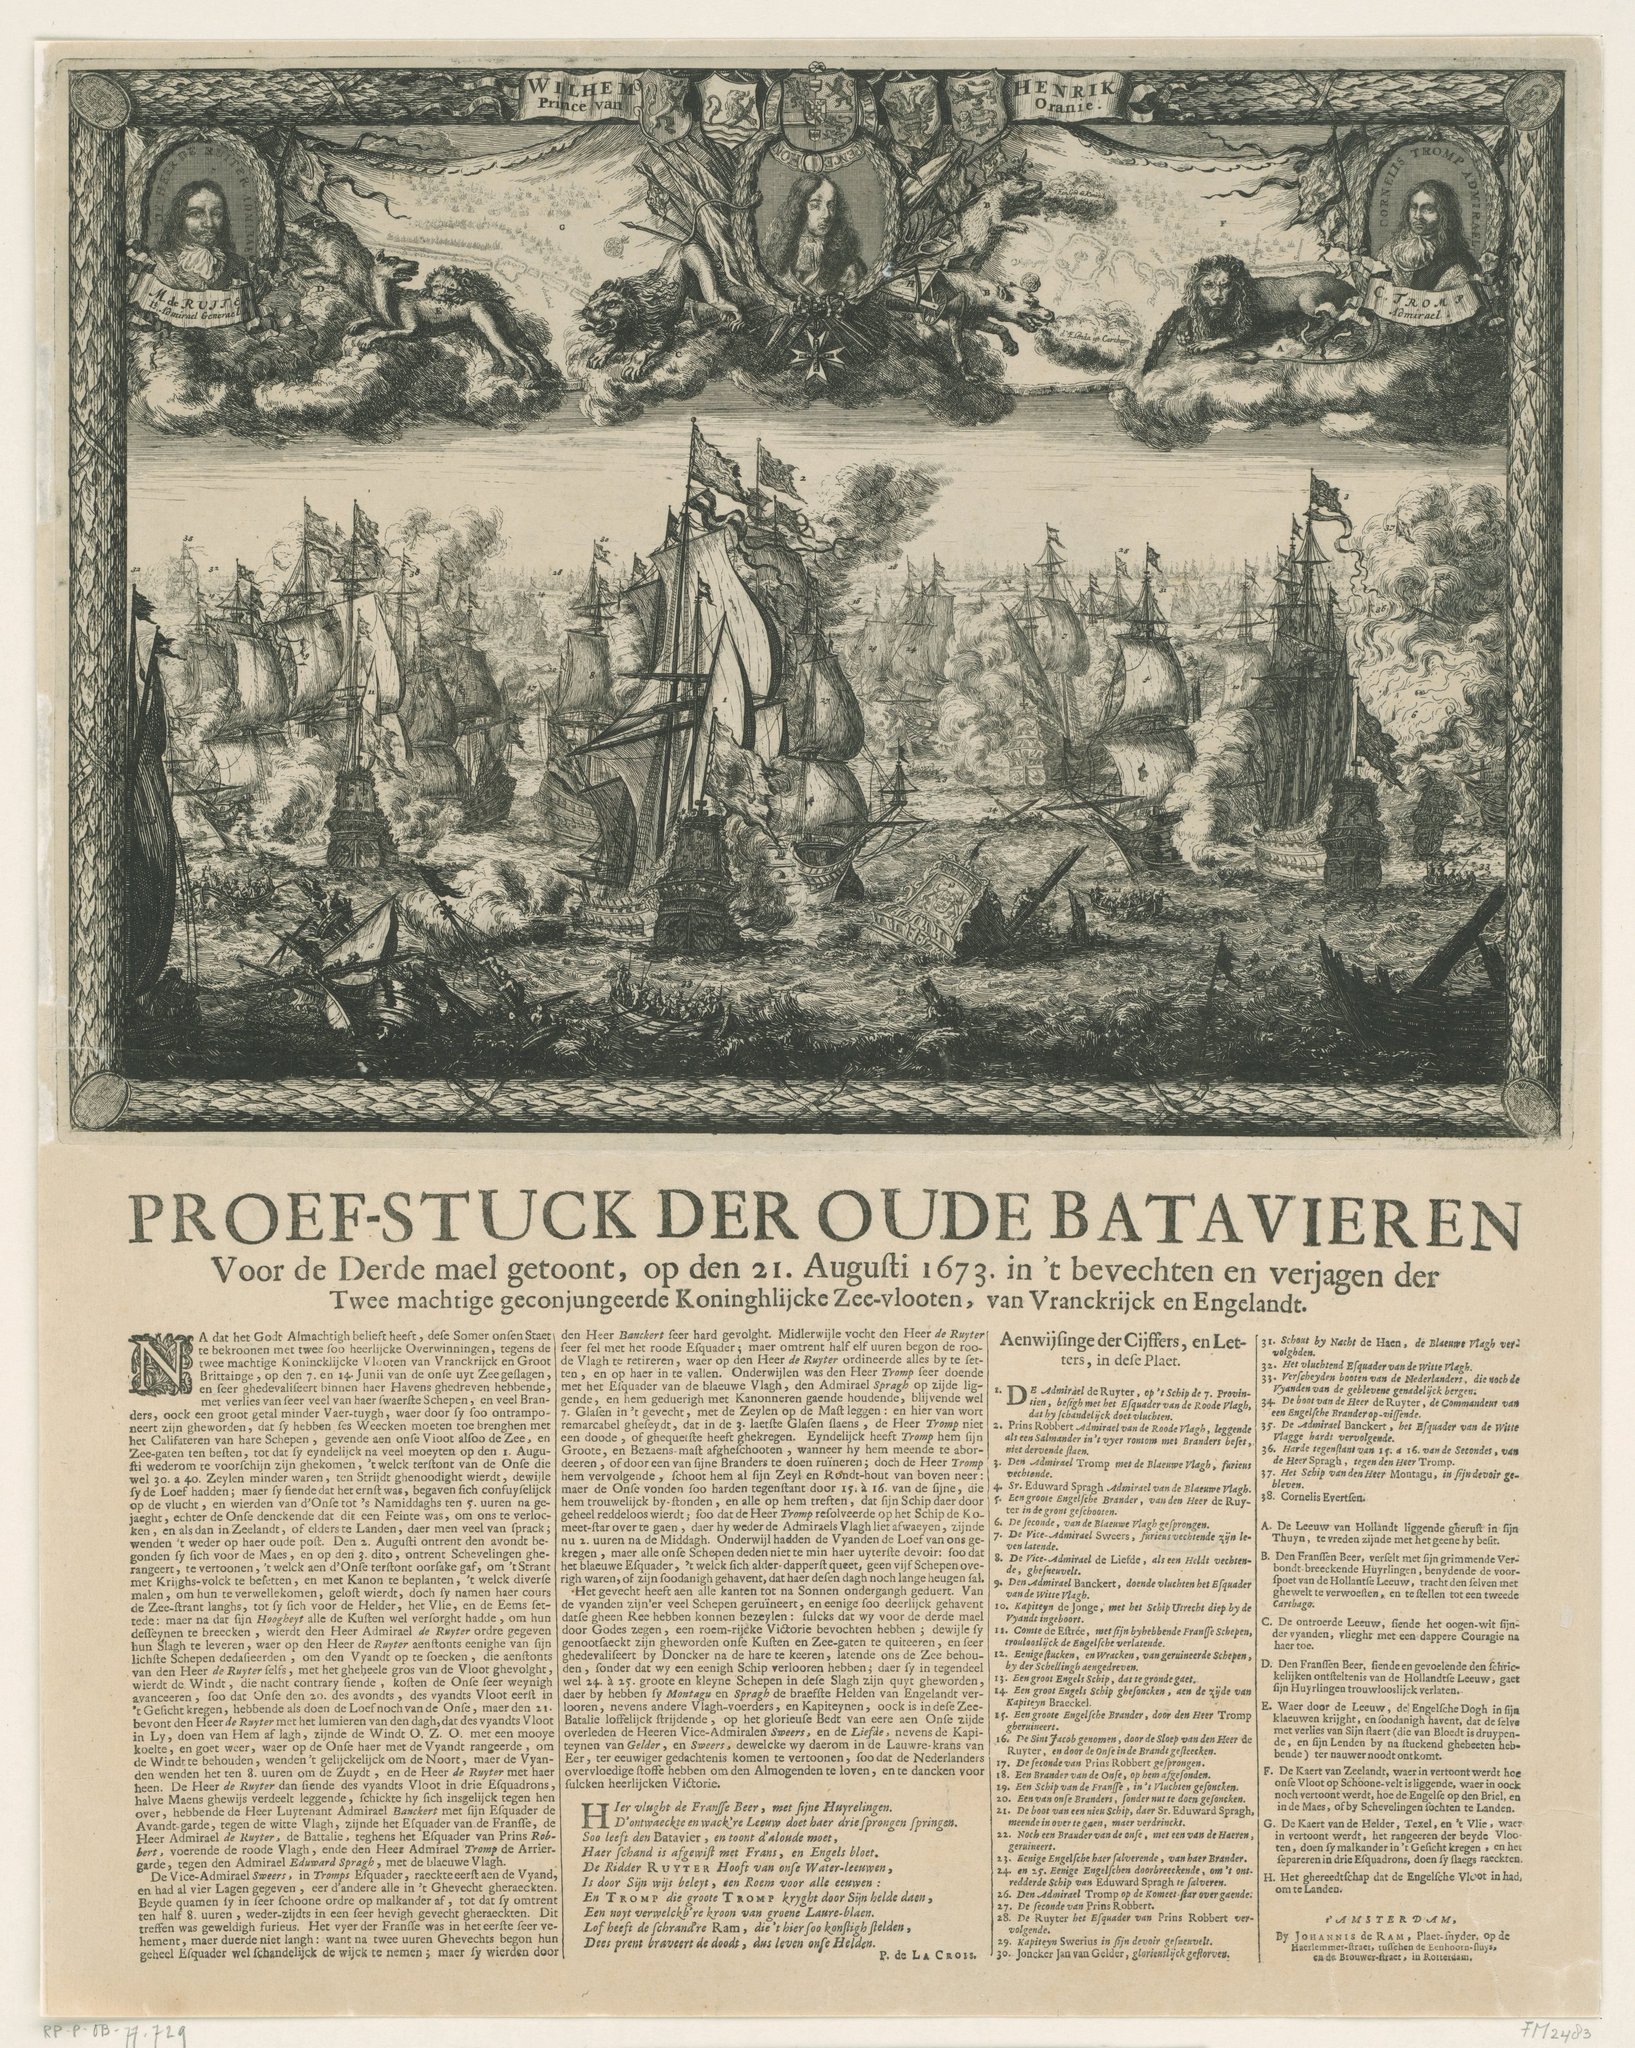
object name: print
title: Zeeslag bij Kijkduin, 1673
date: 1673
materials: paper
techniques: etching, letterpress printing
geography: rotterdam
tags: flushing, michiel adriaenszoon de ruyter, cornelis tromp, william iii (prince of orange and king of england, scotland, and ireland), battle (+ naval force), battle of the texel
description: Zeeslag bij Kijkduin, 21 augustus 1673. Zeeslag tussen de Staatse vloot onder Michiel Adriaenszoon de Ruyter en Cornelis Tromp en de gecombineerde Engels-Franse vloot onder prins Rupert. Boven de slag in het midden het portret van Willem III, links portret van De Ruyter, rechts van Tromp. Onder de plaat een tekstblad met beschrijving van de slag, een vers en de legenda's 1-38 en A-H.